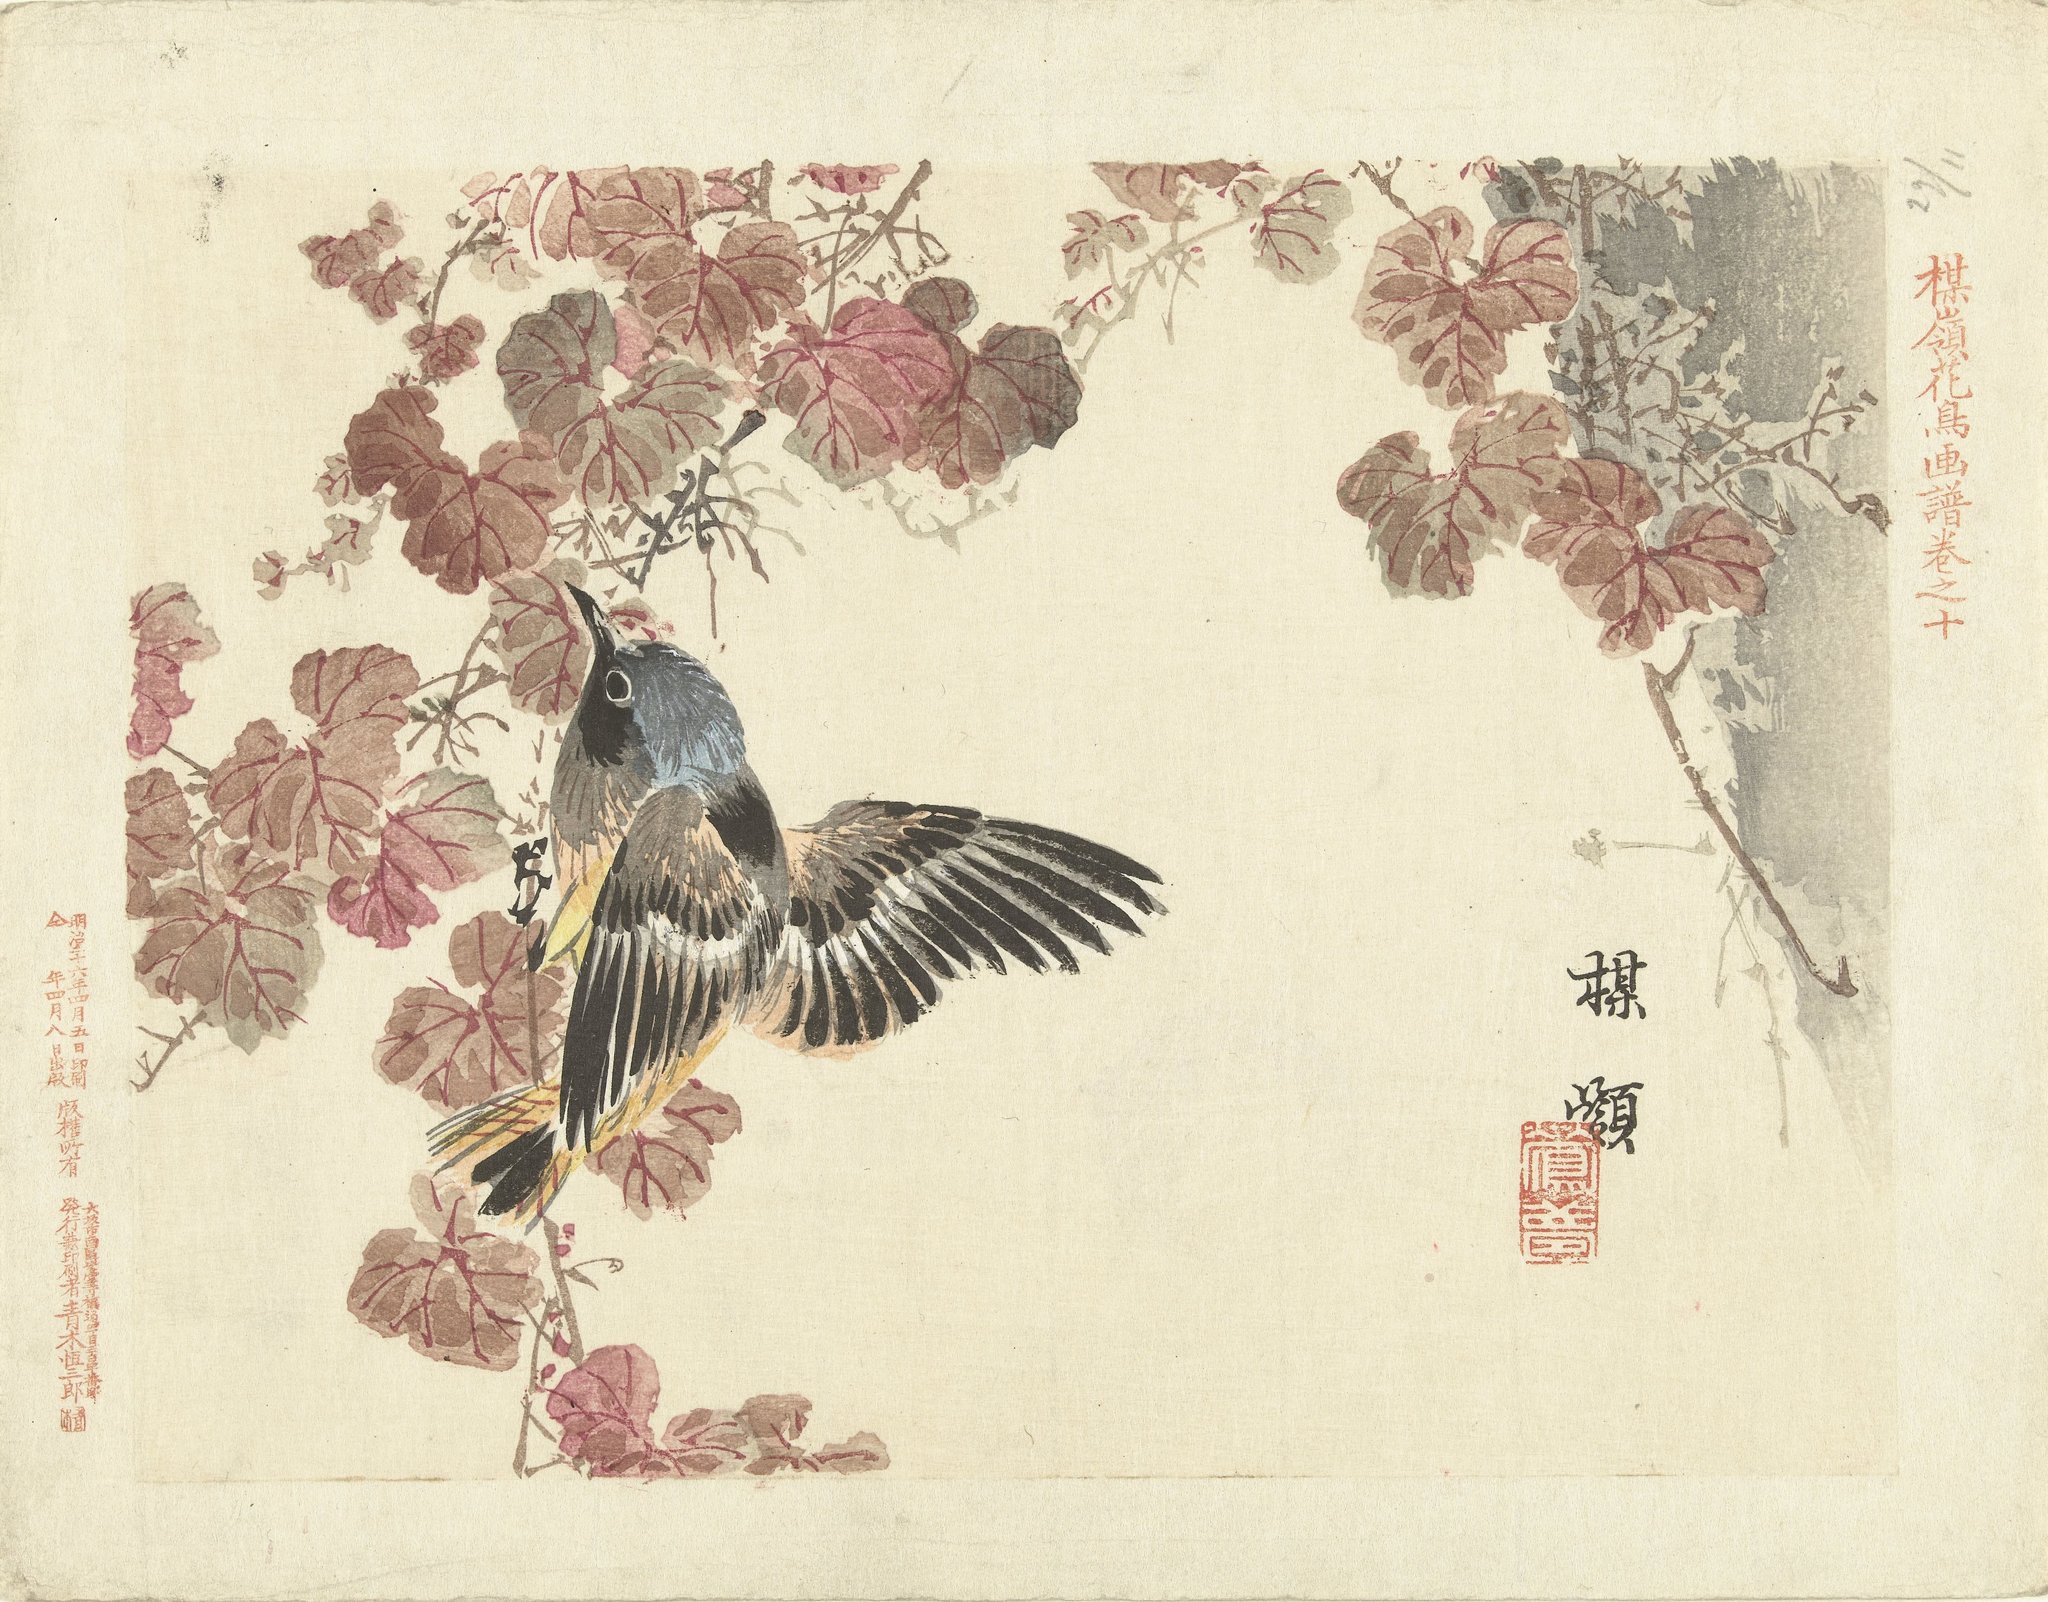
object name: print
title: Bird and red vine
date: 1804-1893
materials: paper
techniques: woodcut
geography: osaka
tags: plants; vegetation, birds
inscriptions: collector's mark: Lugt 2228, collector's mark: ‘Rijksschool voor kunstnijverheid’ Lugt 3937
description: Vogel met blauwe kop, bij een tak met rood blad.